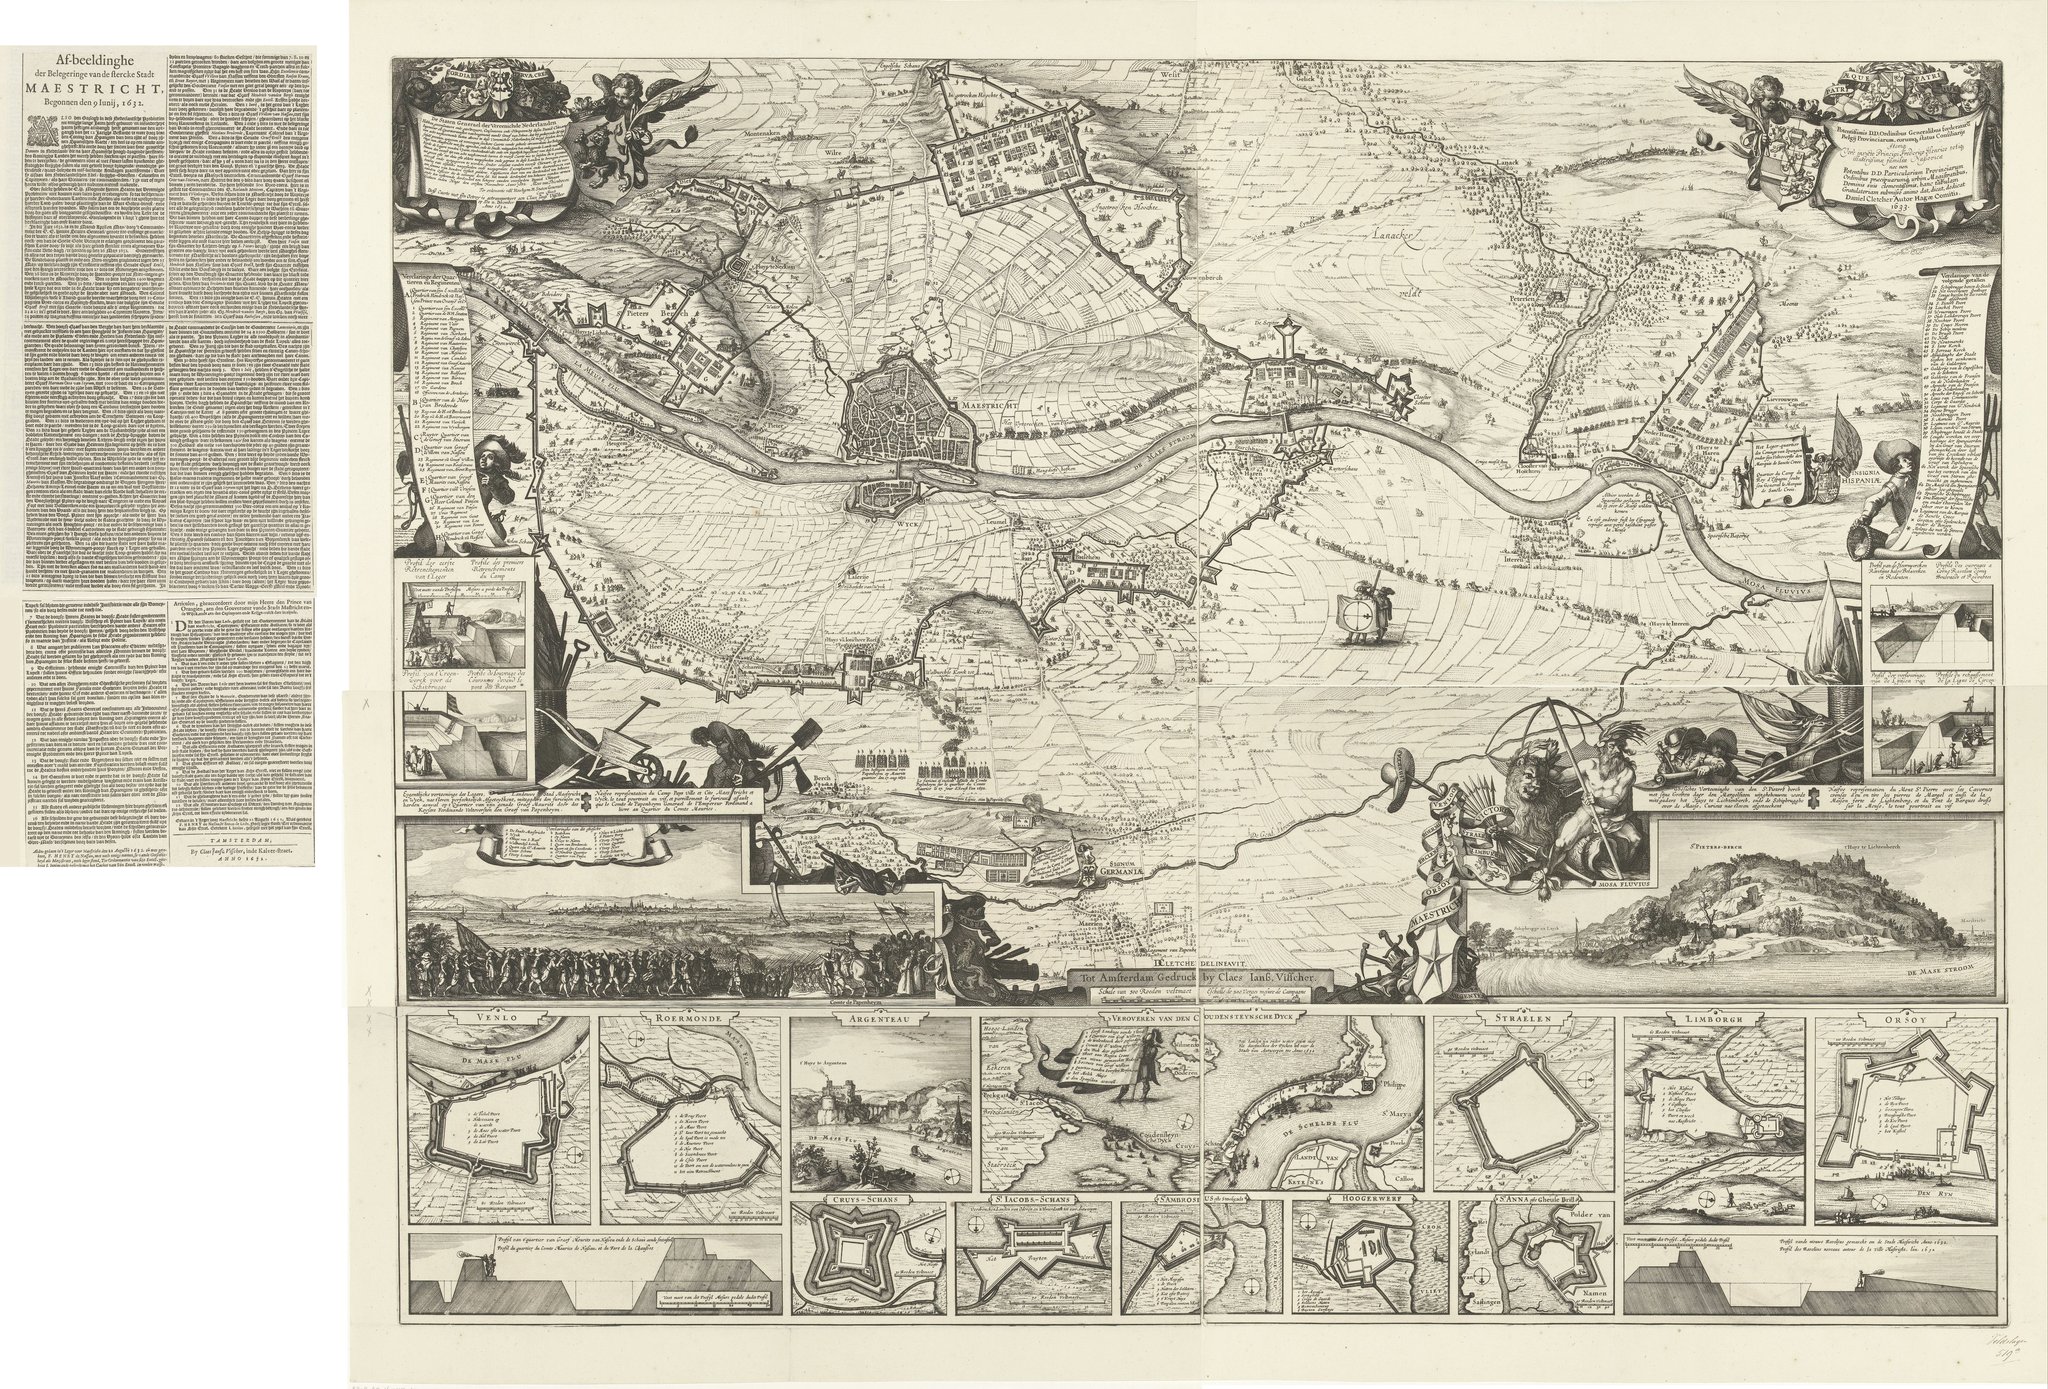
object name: print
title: Siege of Maastricht, 1632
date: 1633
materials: paper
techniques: etching, letterpress printing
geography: amsterdam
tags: frederick henry (prince of orange), maps of separate countries or regions, siege, position war, maastricht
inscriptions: date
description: Grote samengestelde kaart van het beleg en de inname van Maastricht door het Staatse leger onder stadhouder Frederik Hendrik, 9 juni tot 21 augustus 1632. Kaart samengesteld uit zes bladen, drie links en drie rechts en twee losse tekstbladen.